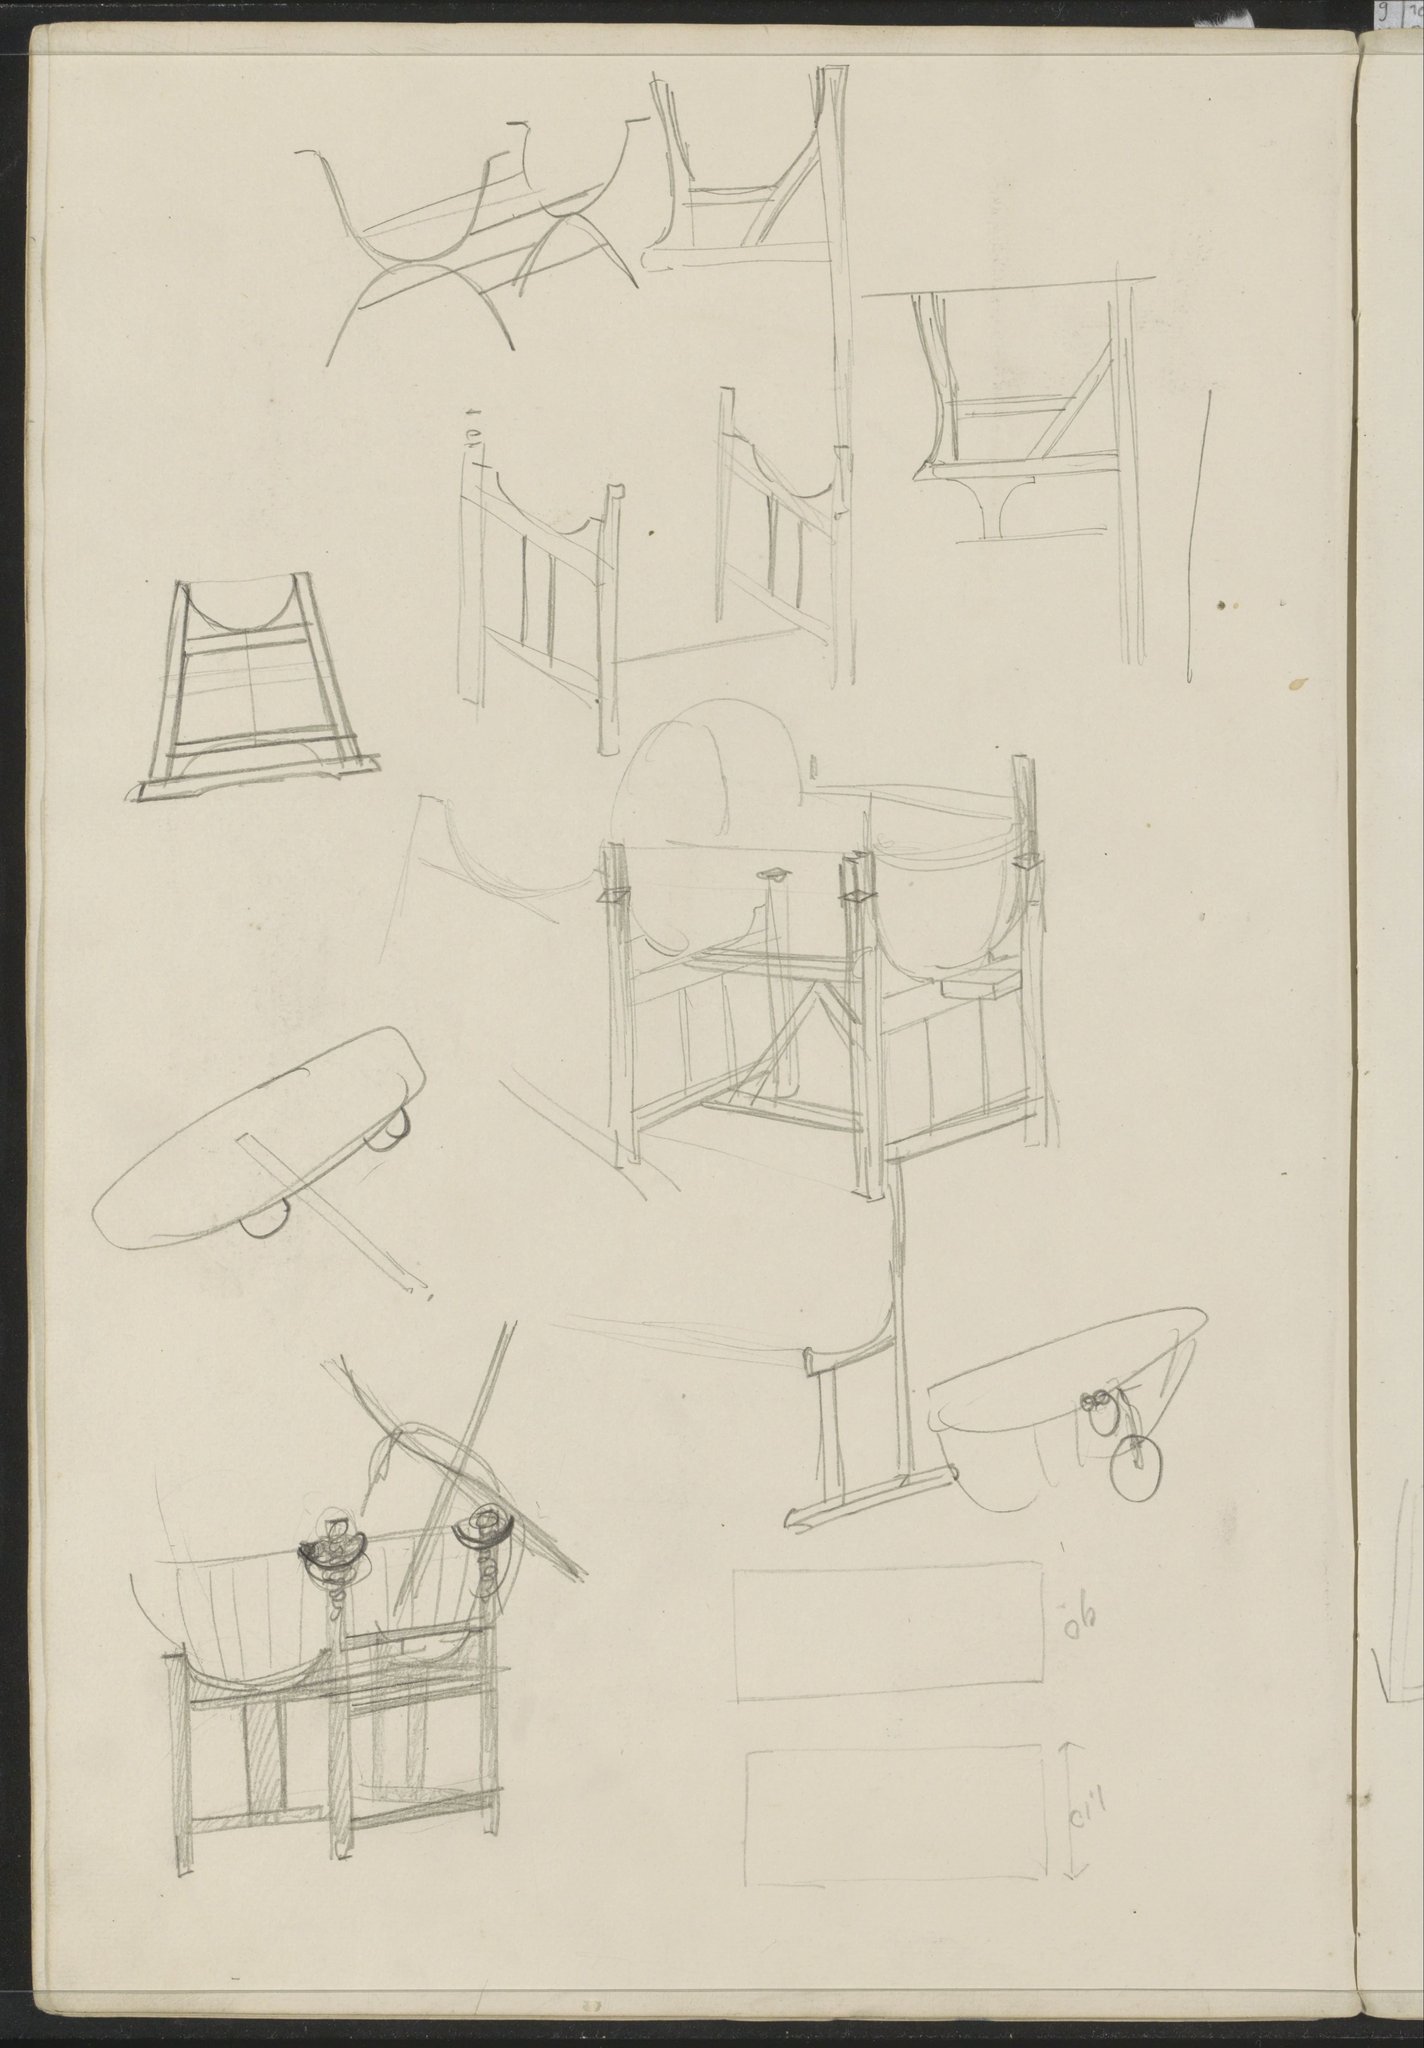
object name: sketchbook leaf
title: Ontwerpen voor een wieg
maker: carel adolph lion cachet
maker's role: draughtsman, print maker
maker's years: 1864-1945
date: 1903-1904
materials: paper, pencil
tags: cradle, crib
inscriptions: annotation: ‘[...]’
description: Blad 8 verso uit een schetsboek met 17 bladen.